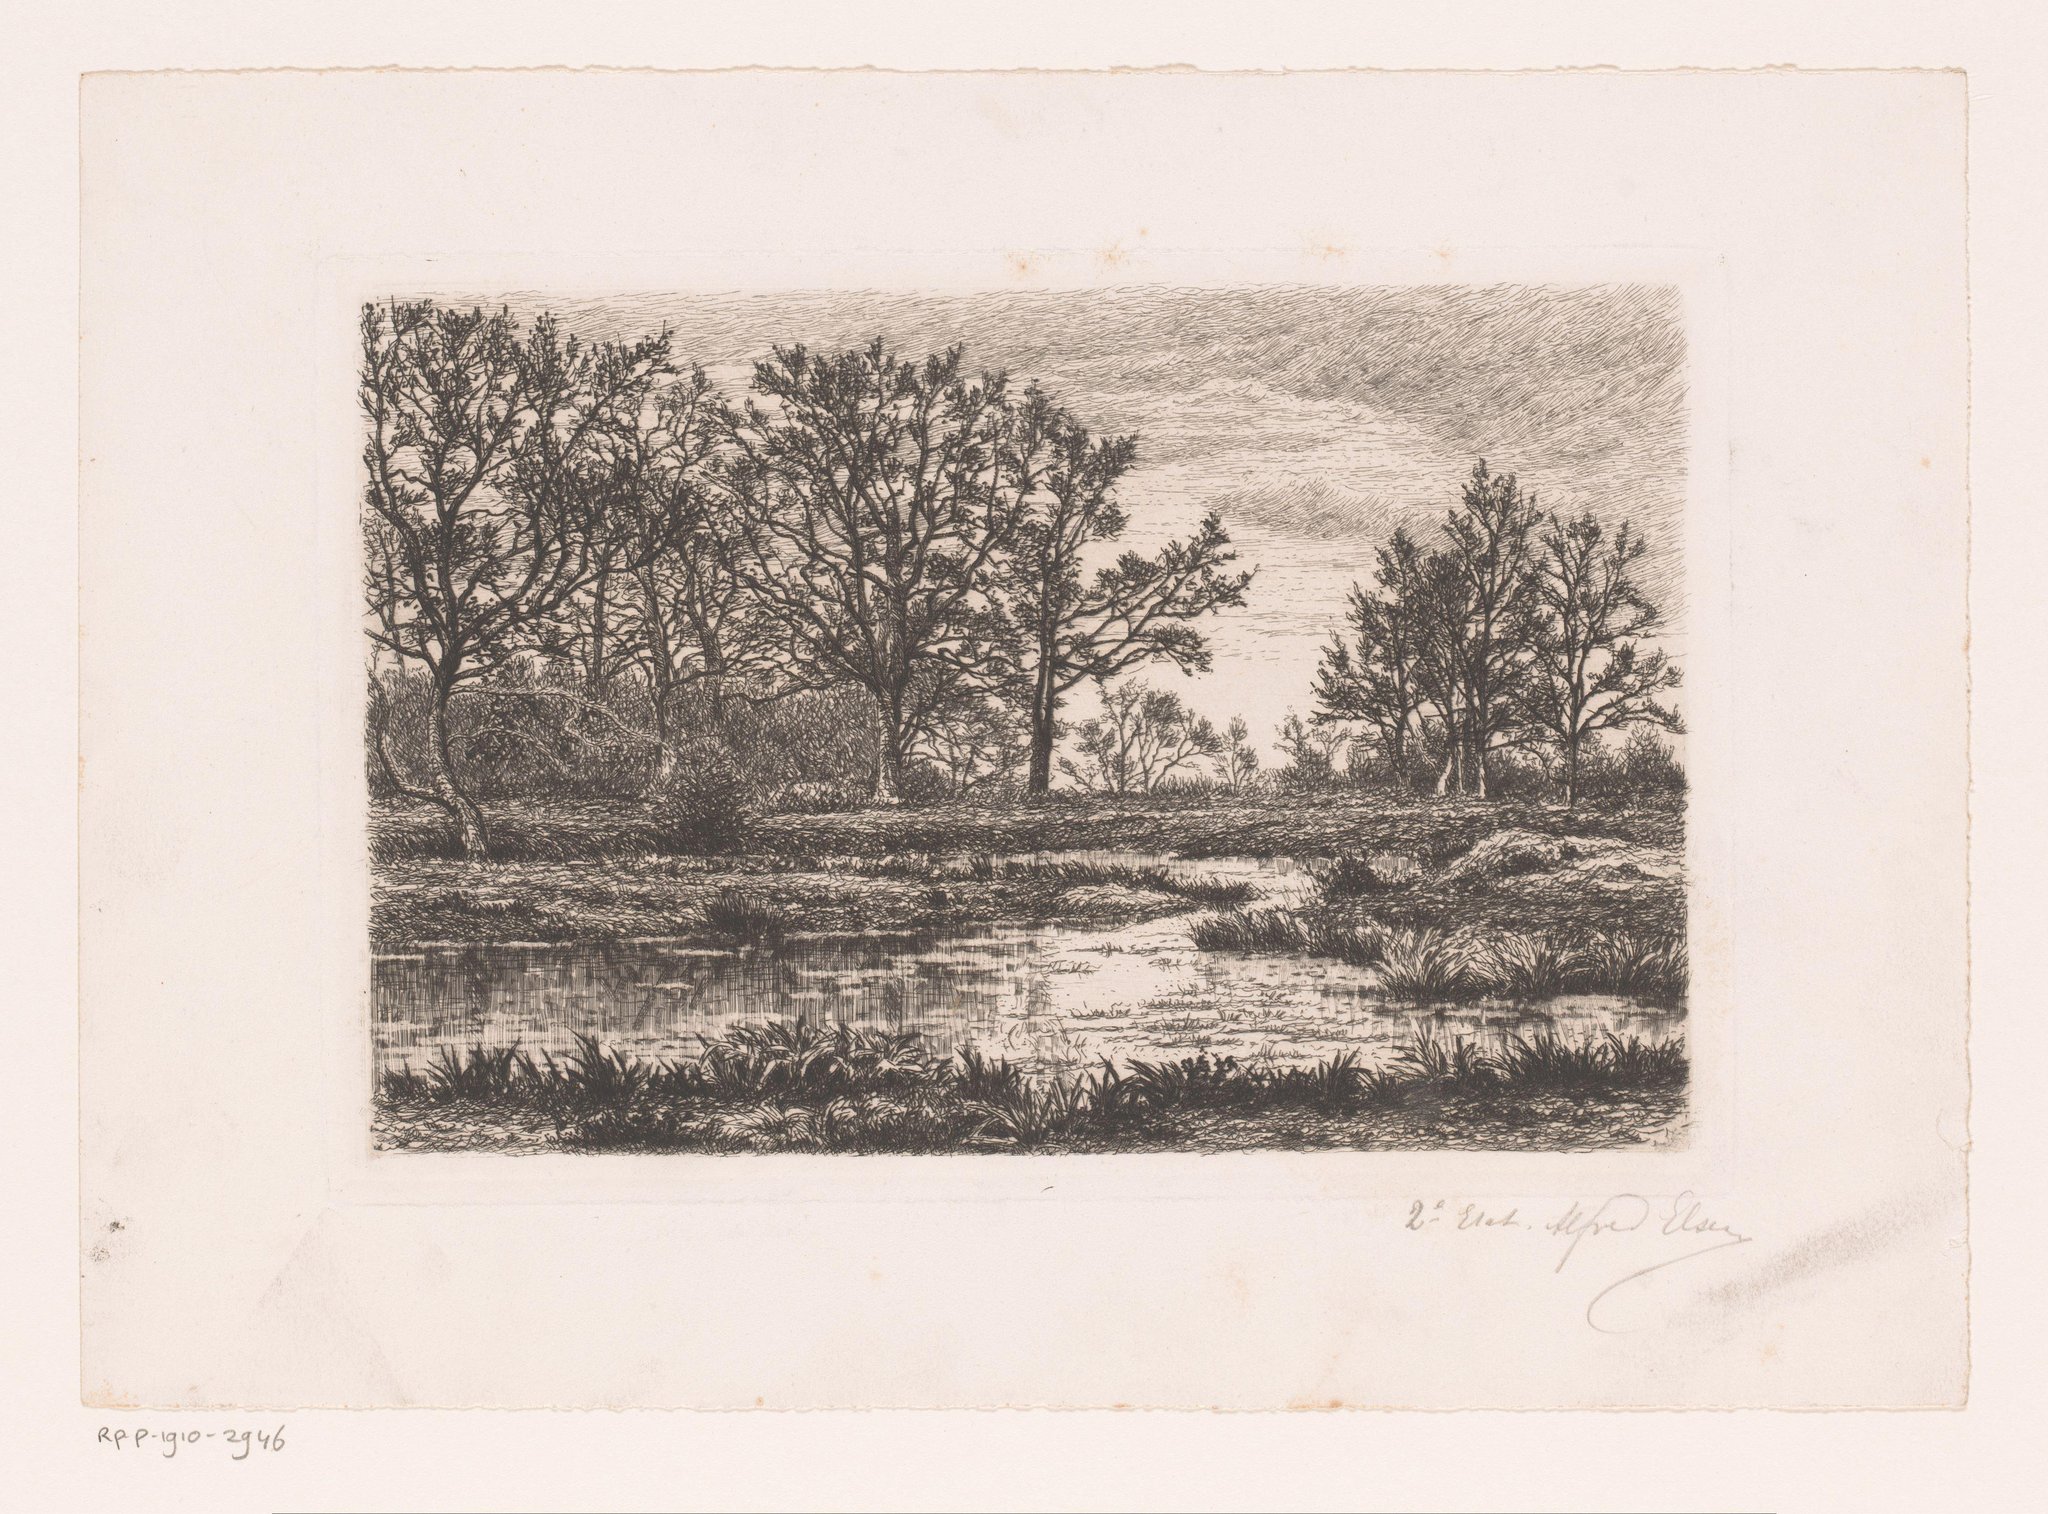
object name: print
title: Moeraslandschap met bomen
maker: alfred elsen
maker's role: painter, print maker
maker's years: 1850-1914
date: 1860-1910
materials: paper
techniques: etching, intaglio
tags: swamp, inland marsh, fens, trees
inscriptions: inscription: ‘2e Etat’, collector's mark: Lugt 2228